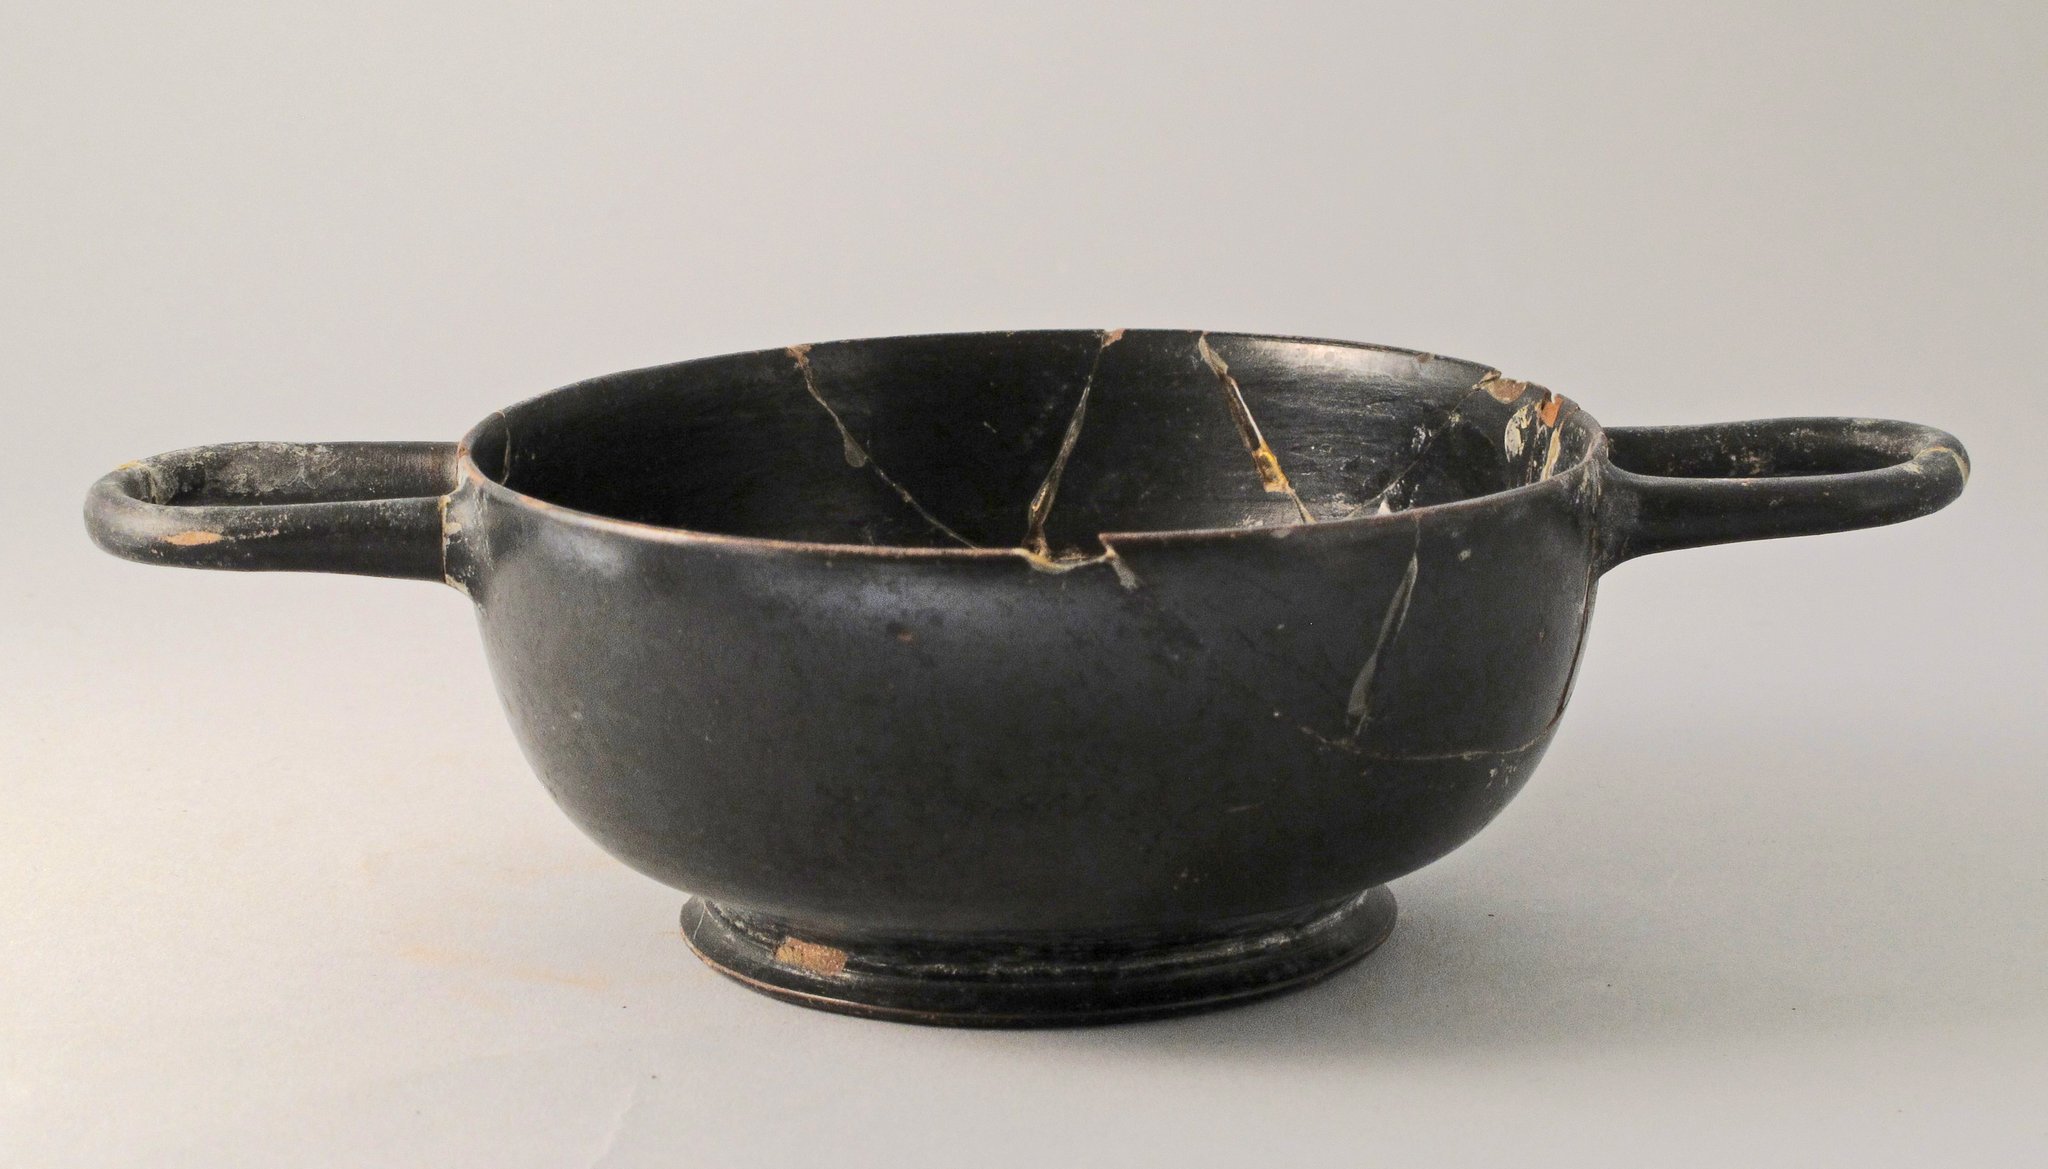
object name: skyphos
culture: greek, attic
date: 450-400 BCE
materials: terracotta